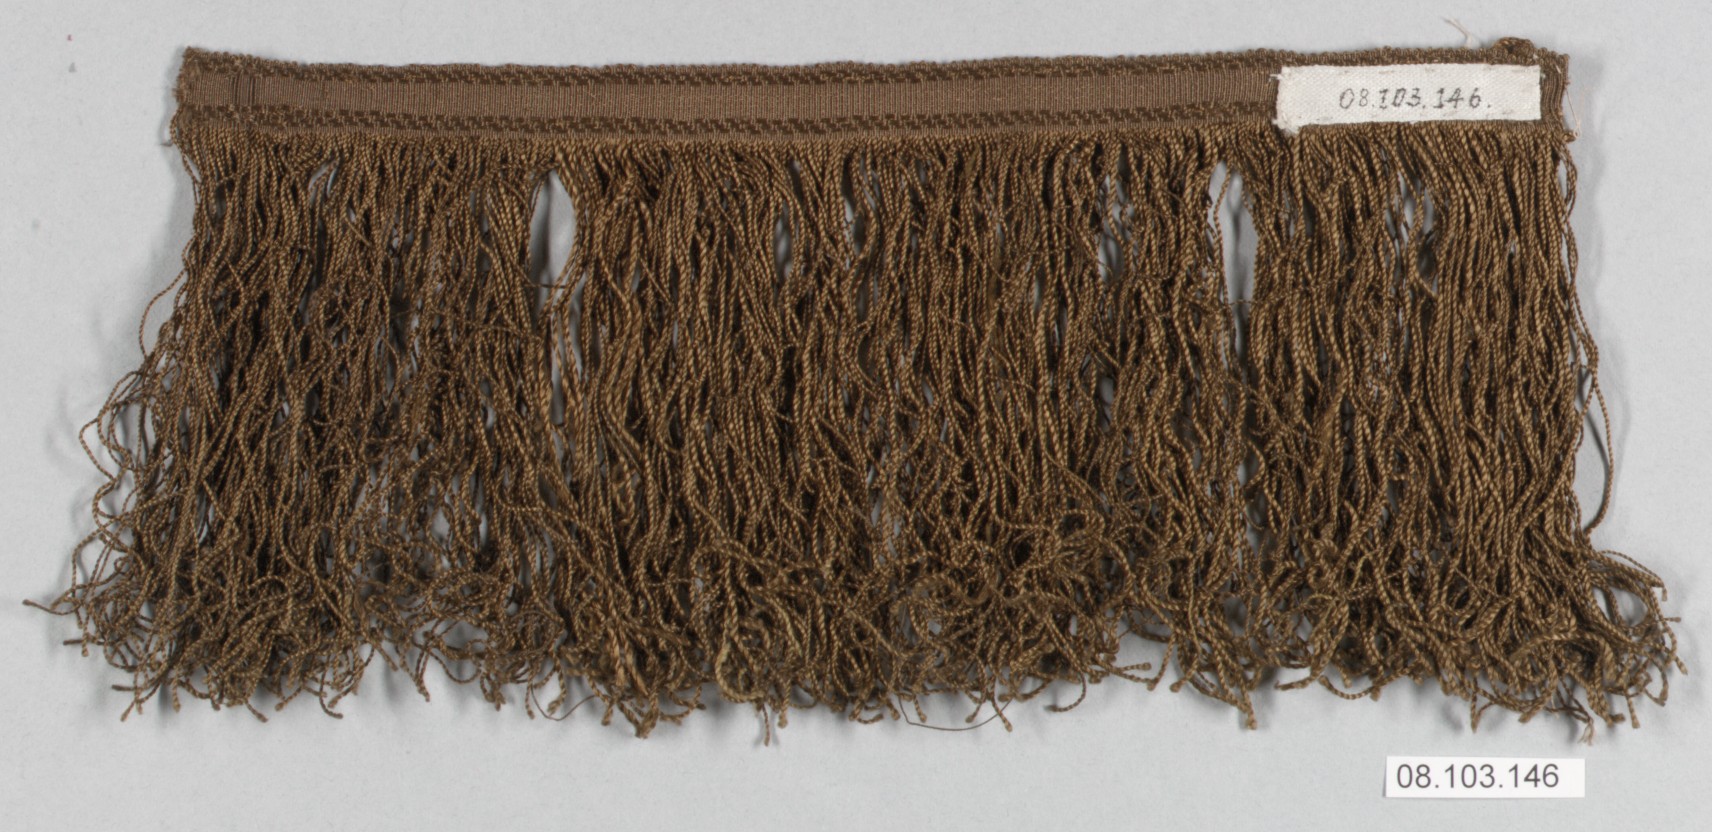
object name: fringe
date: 1801-1900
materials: silk